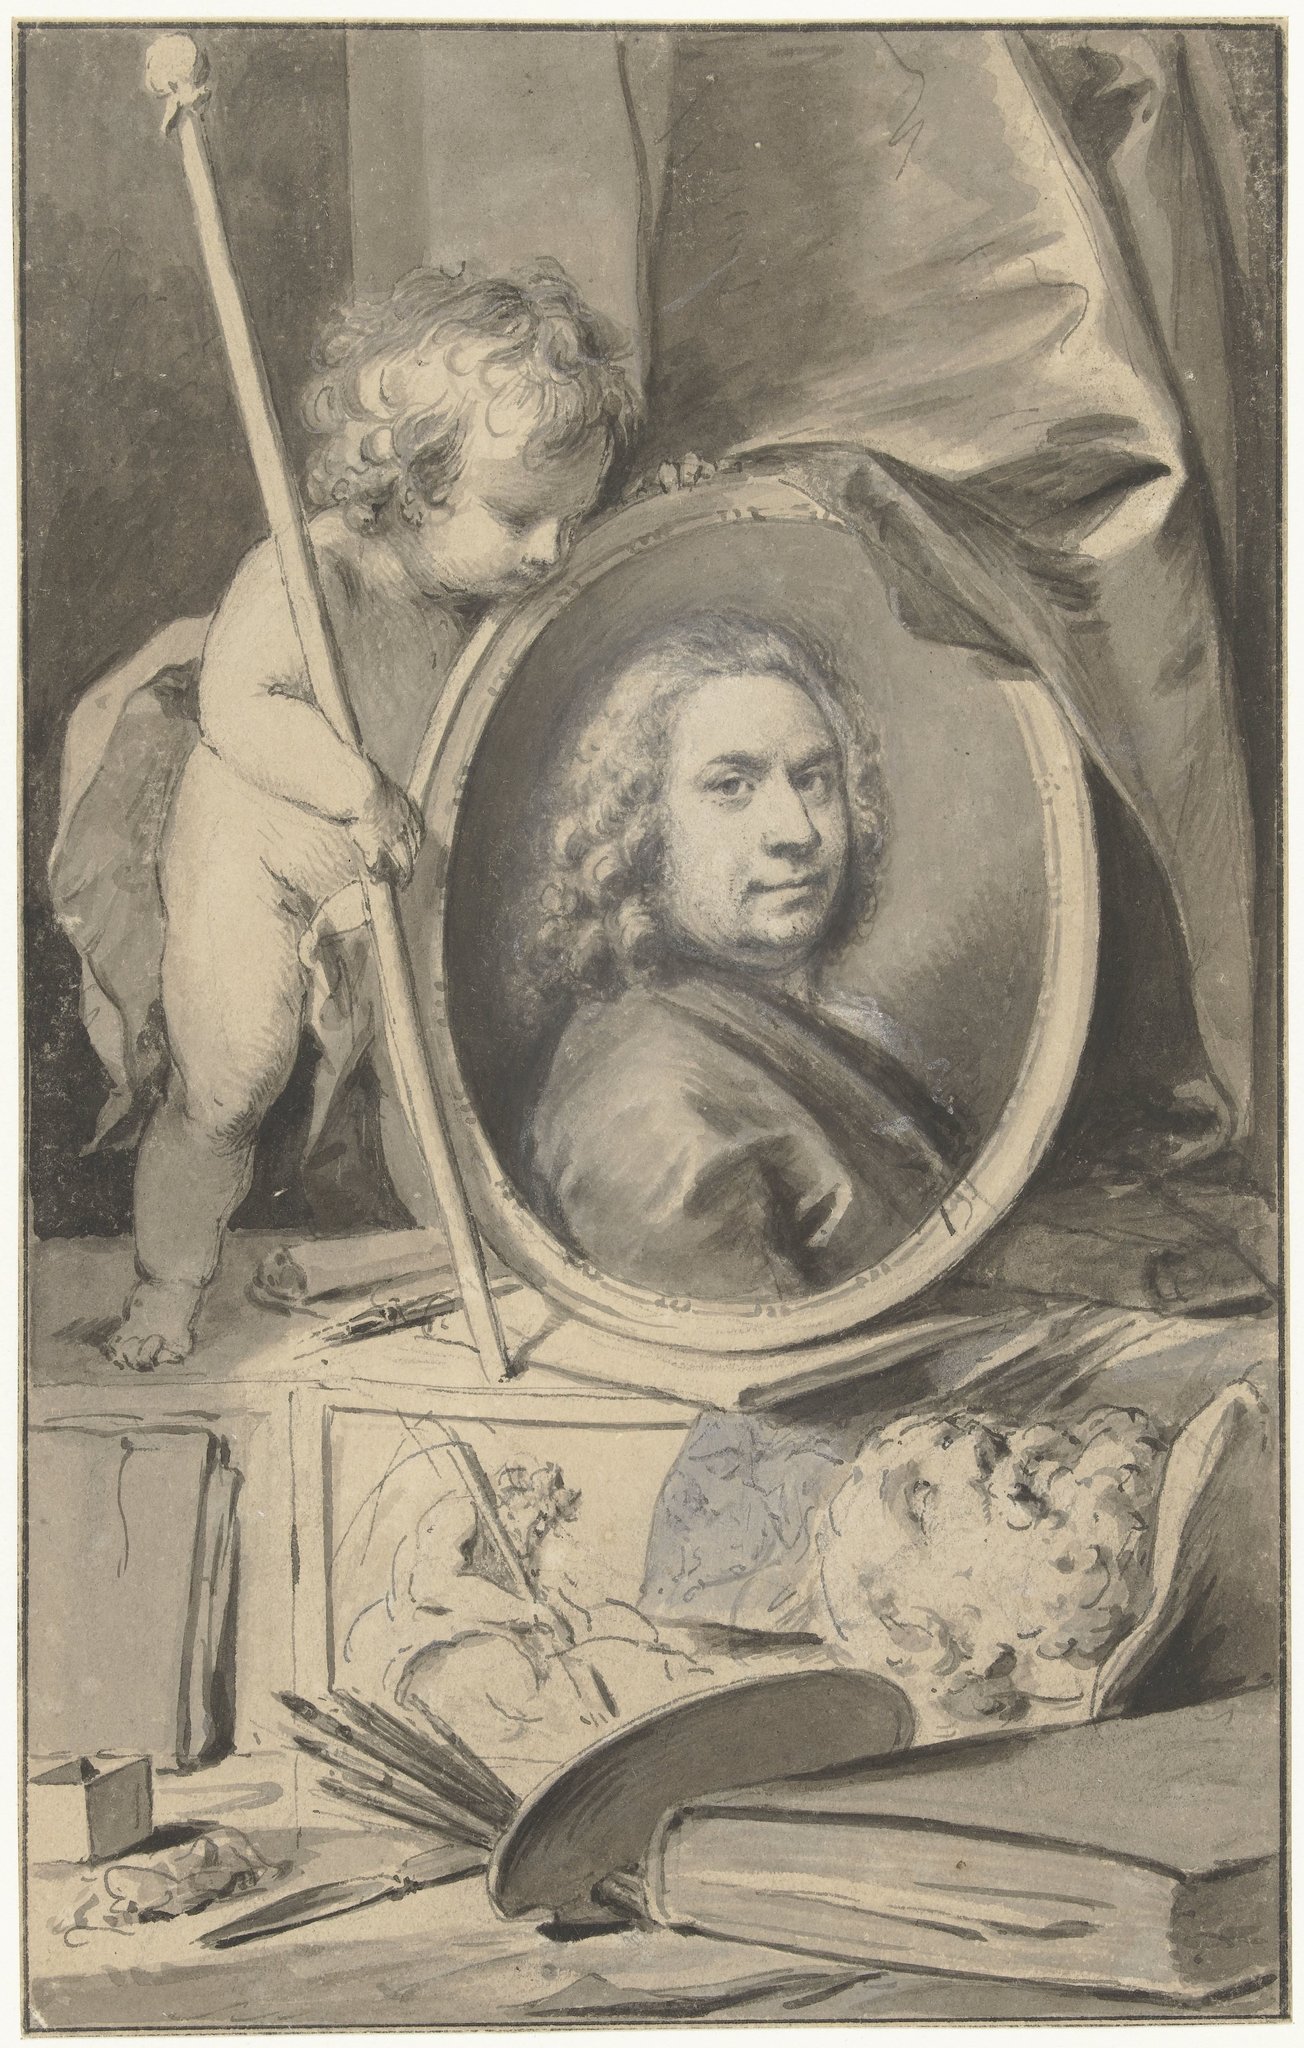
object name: drawing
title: Zelfportret in medaillon omringd door schildersattributen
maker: jacob de wit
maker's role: draughtsman, painter, print maker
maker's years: 1695-1754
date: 1705-1754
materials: paint, ink, paper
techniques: brush, pen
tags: amsterdam, painter, draughtsman, jacob de wit, historical persons, portrait, self-portrait of painter, tools, implements of painter, portrait, self-portrait of artist